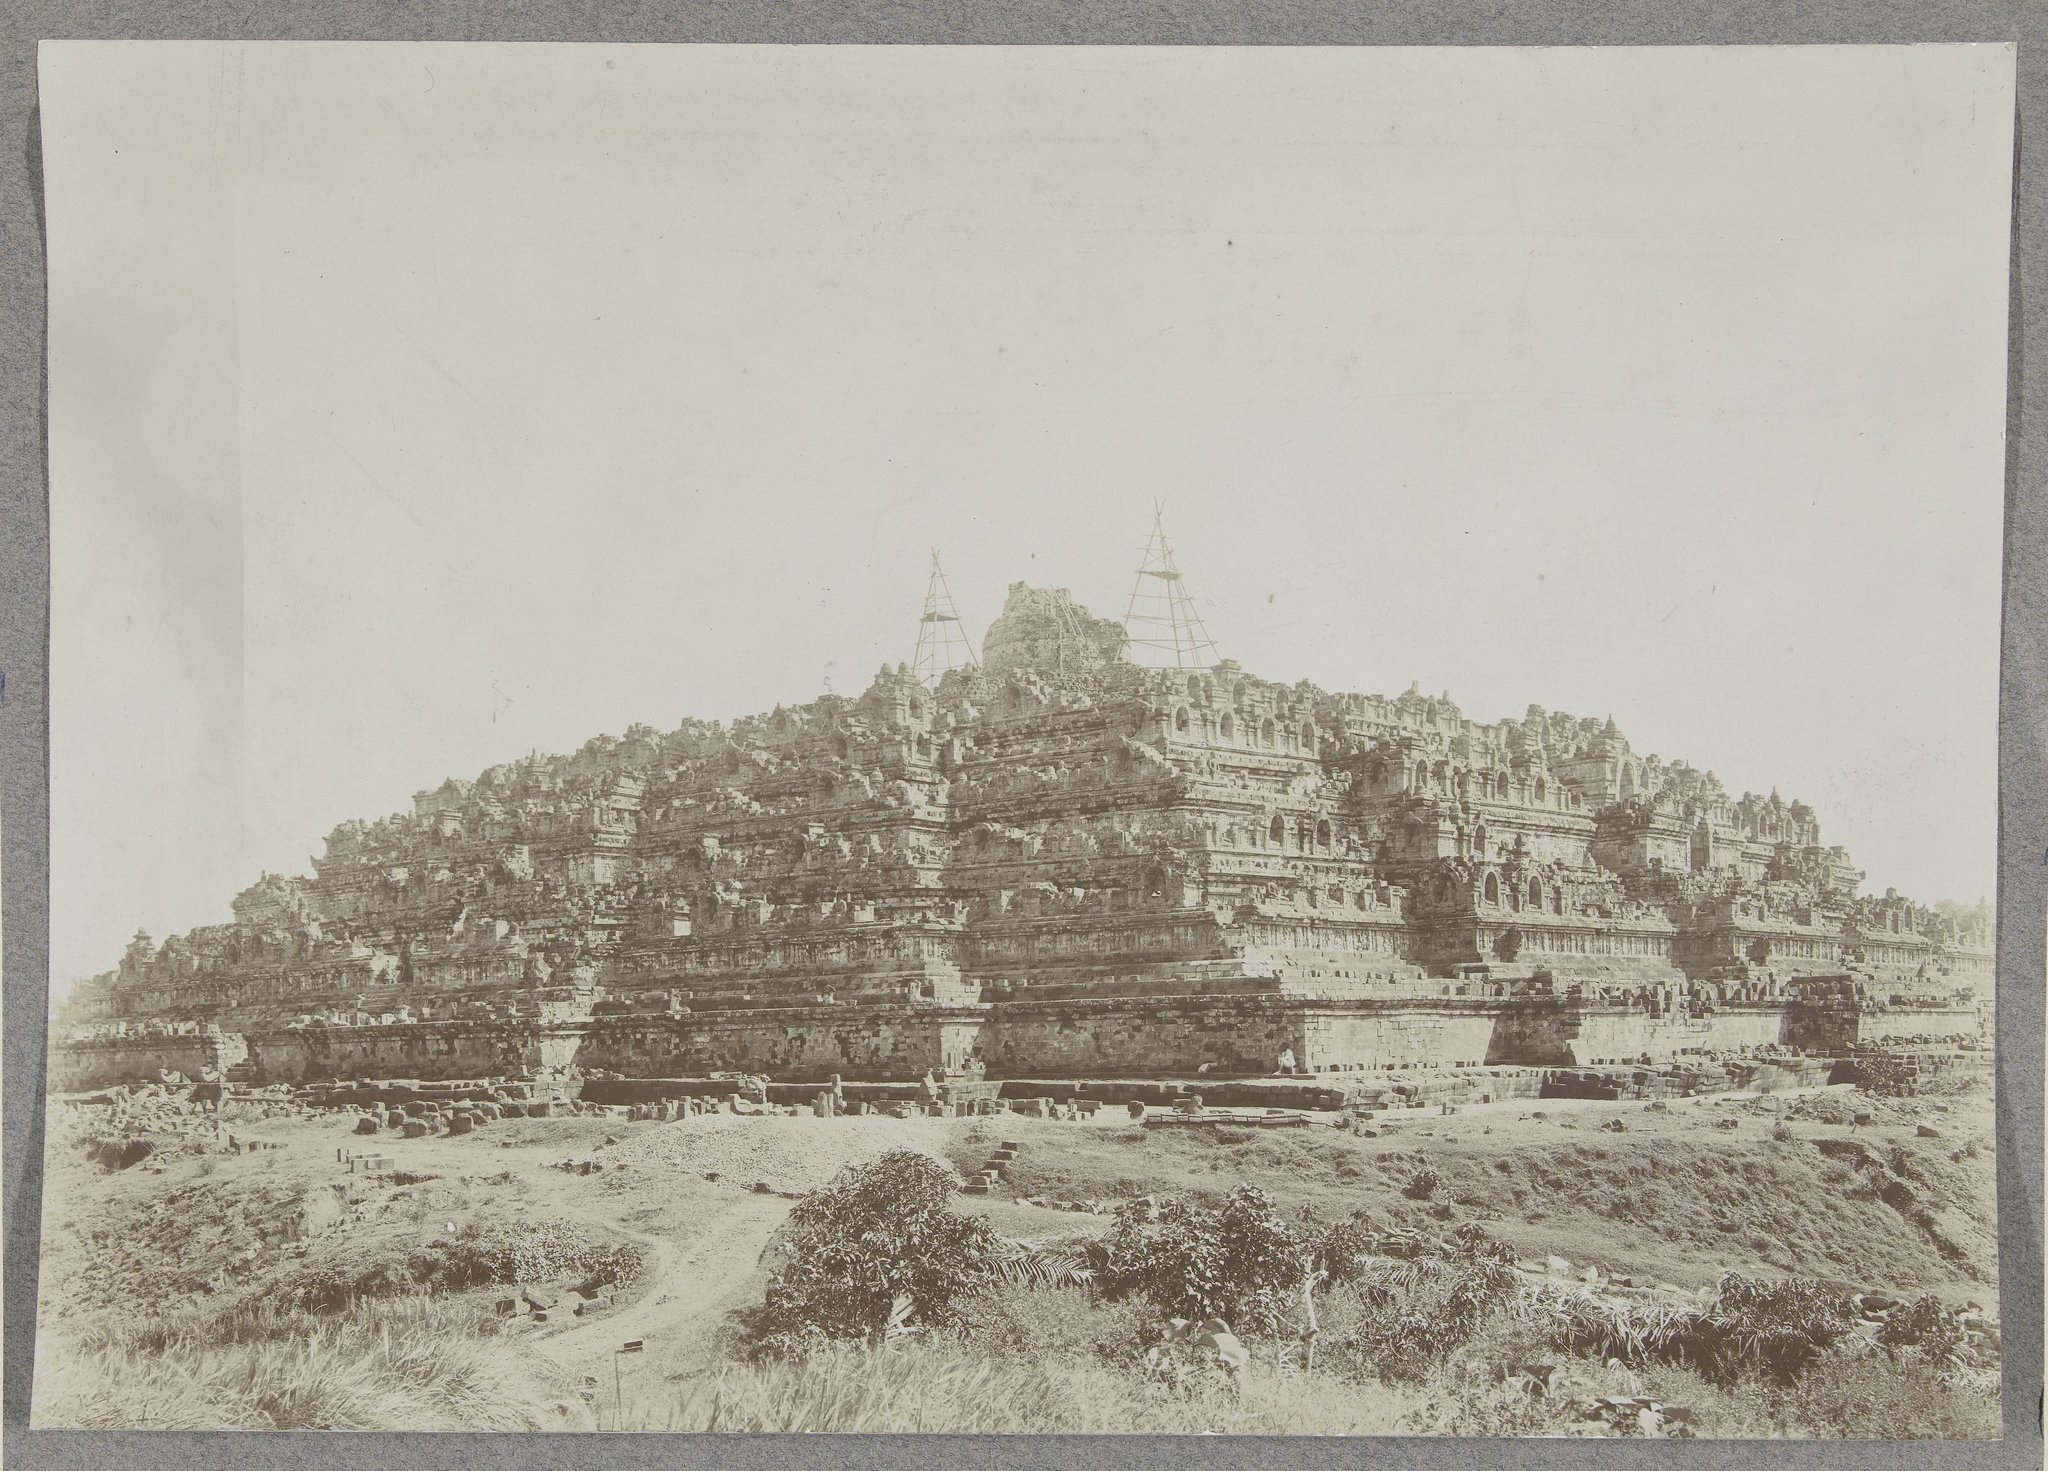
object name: photograph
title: Gezicht op de Borobudur tijdens de restauratie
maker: Anonymous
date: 1907-1911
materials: paper, cardboard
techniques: matte daylight collodion silver print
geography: borobudur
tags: temple, shrine ~ hinduism, buddhism, jainism, restoration of a work of art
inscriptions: stamp: ‘Genootschap Architectura et Amicitia/ Amsterdam’